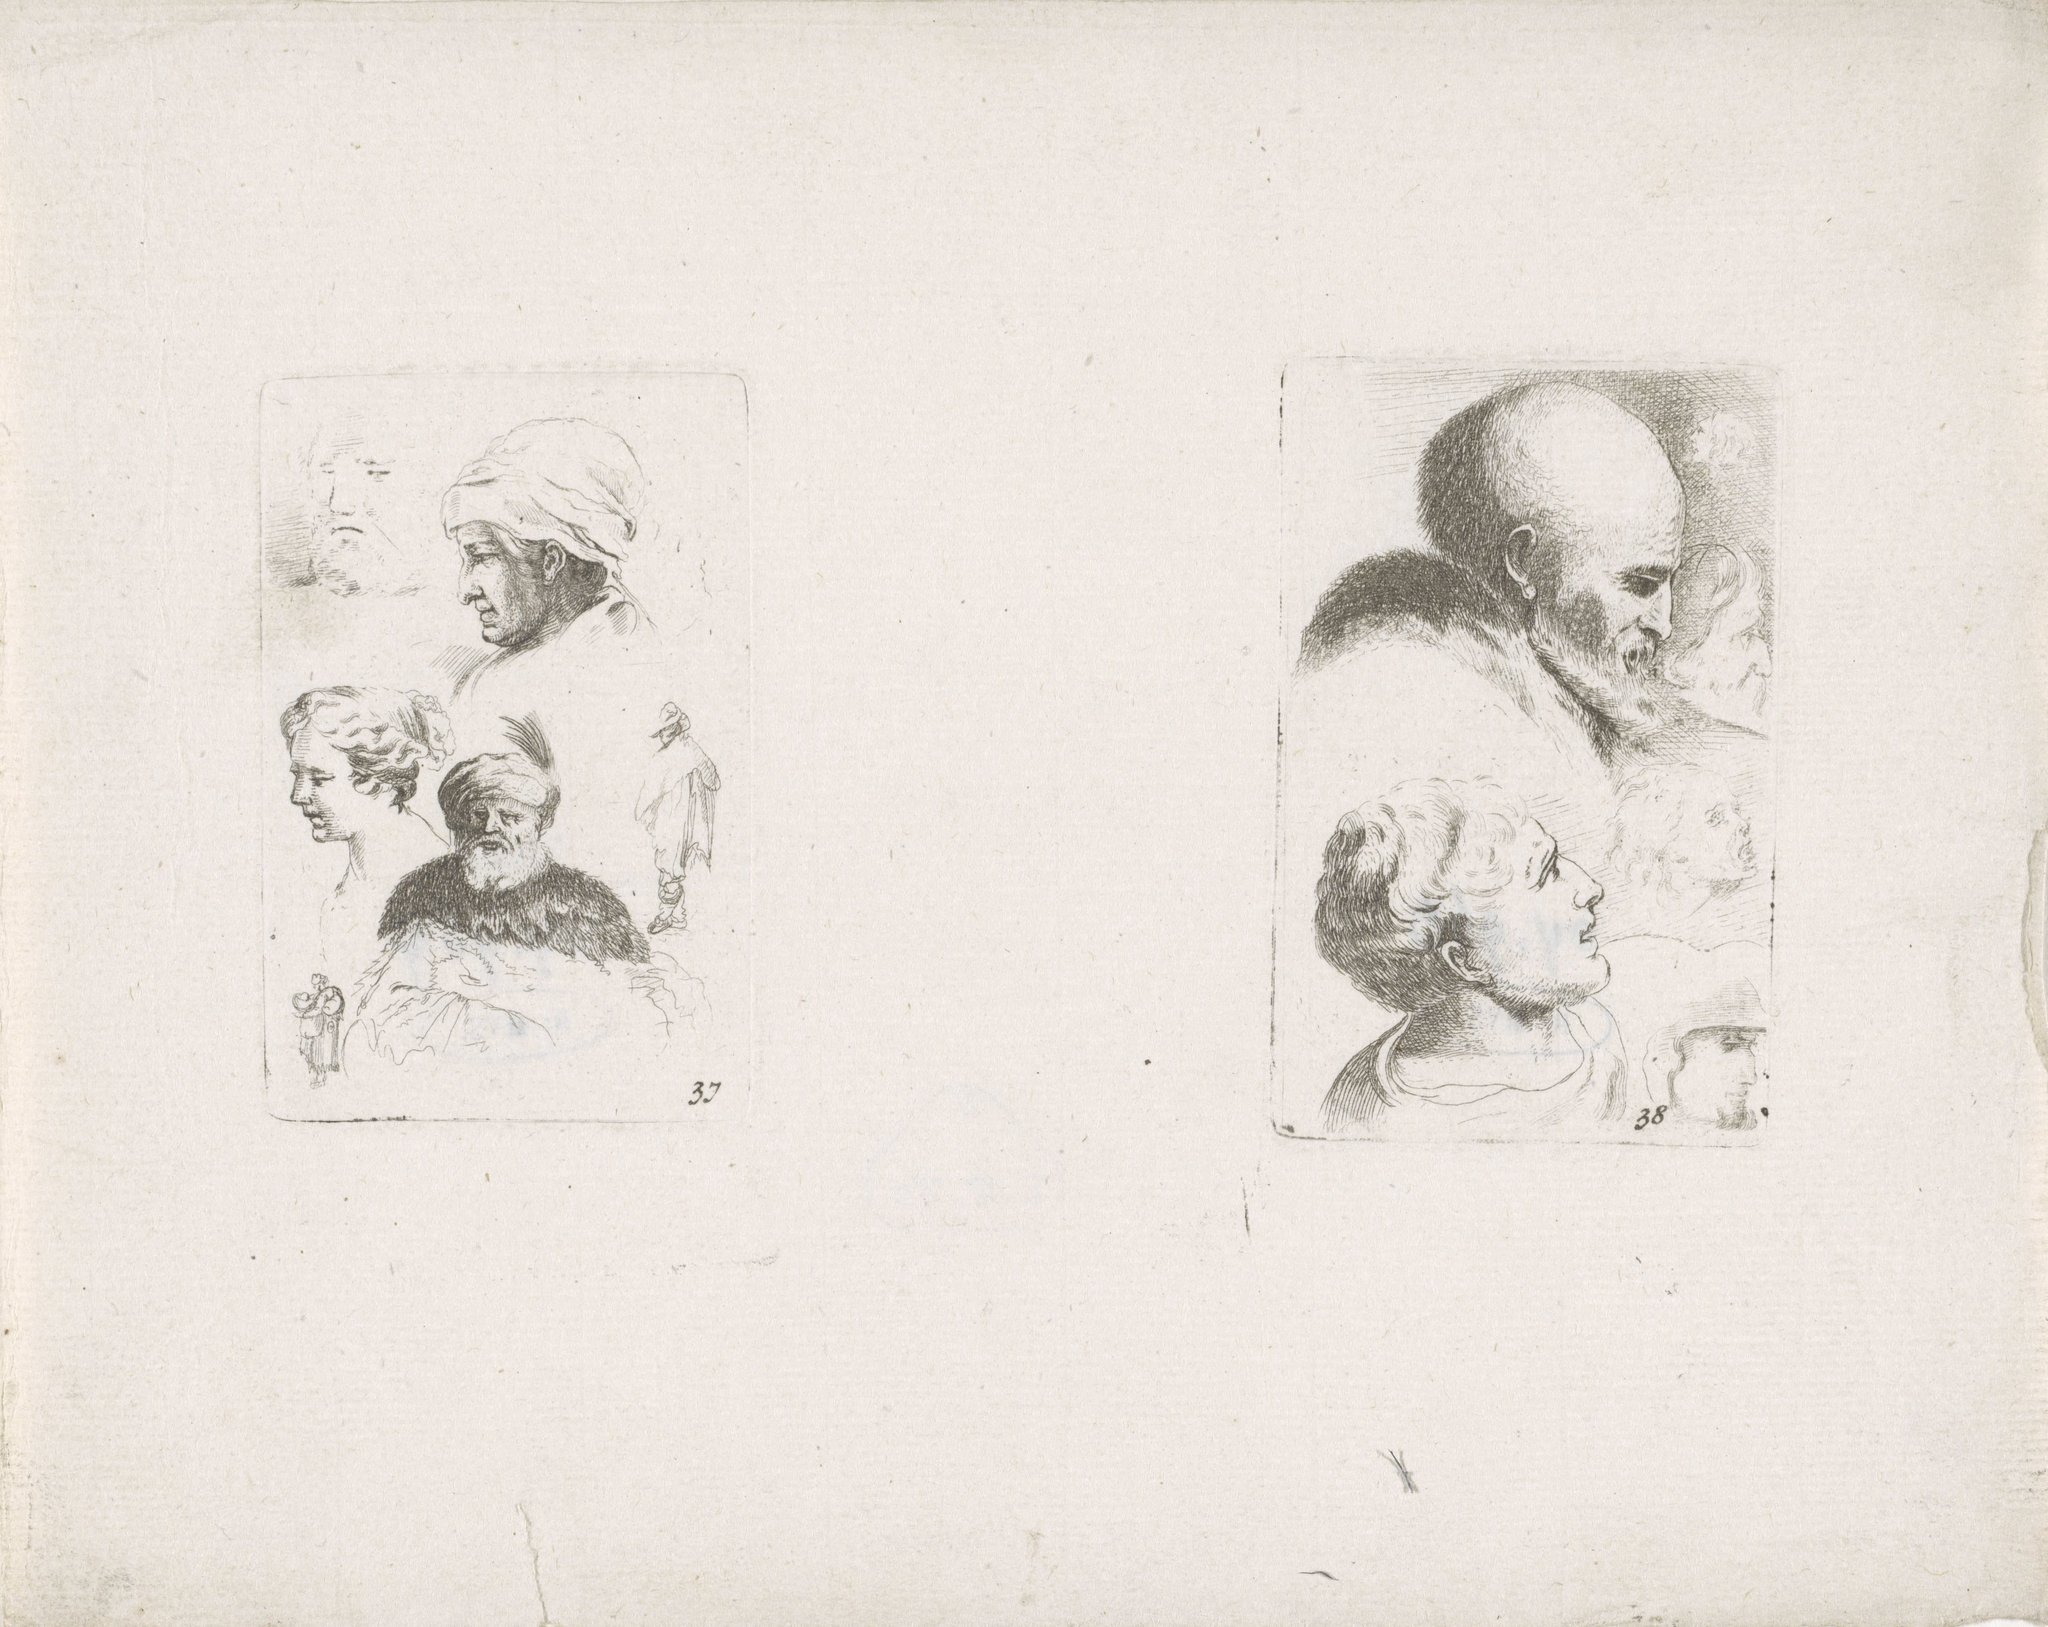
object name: print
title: Tekenvoorbeelden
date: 1620-1664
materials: paper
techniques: etching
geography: amsterdam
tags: head (human), standing figure, head-gear: turban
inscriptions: collector's mark: Lugt 2228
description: Blad met twee voorstellingen. Links: vier studies van hoofden en twee staande figuren. Rechts: vijf studies van hoofden.